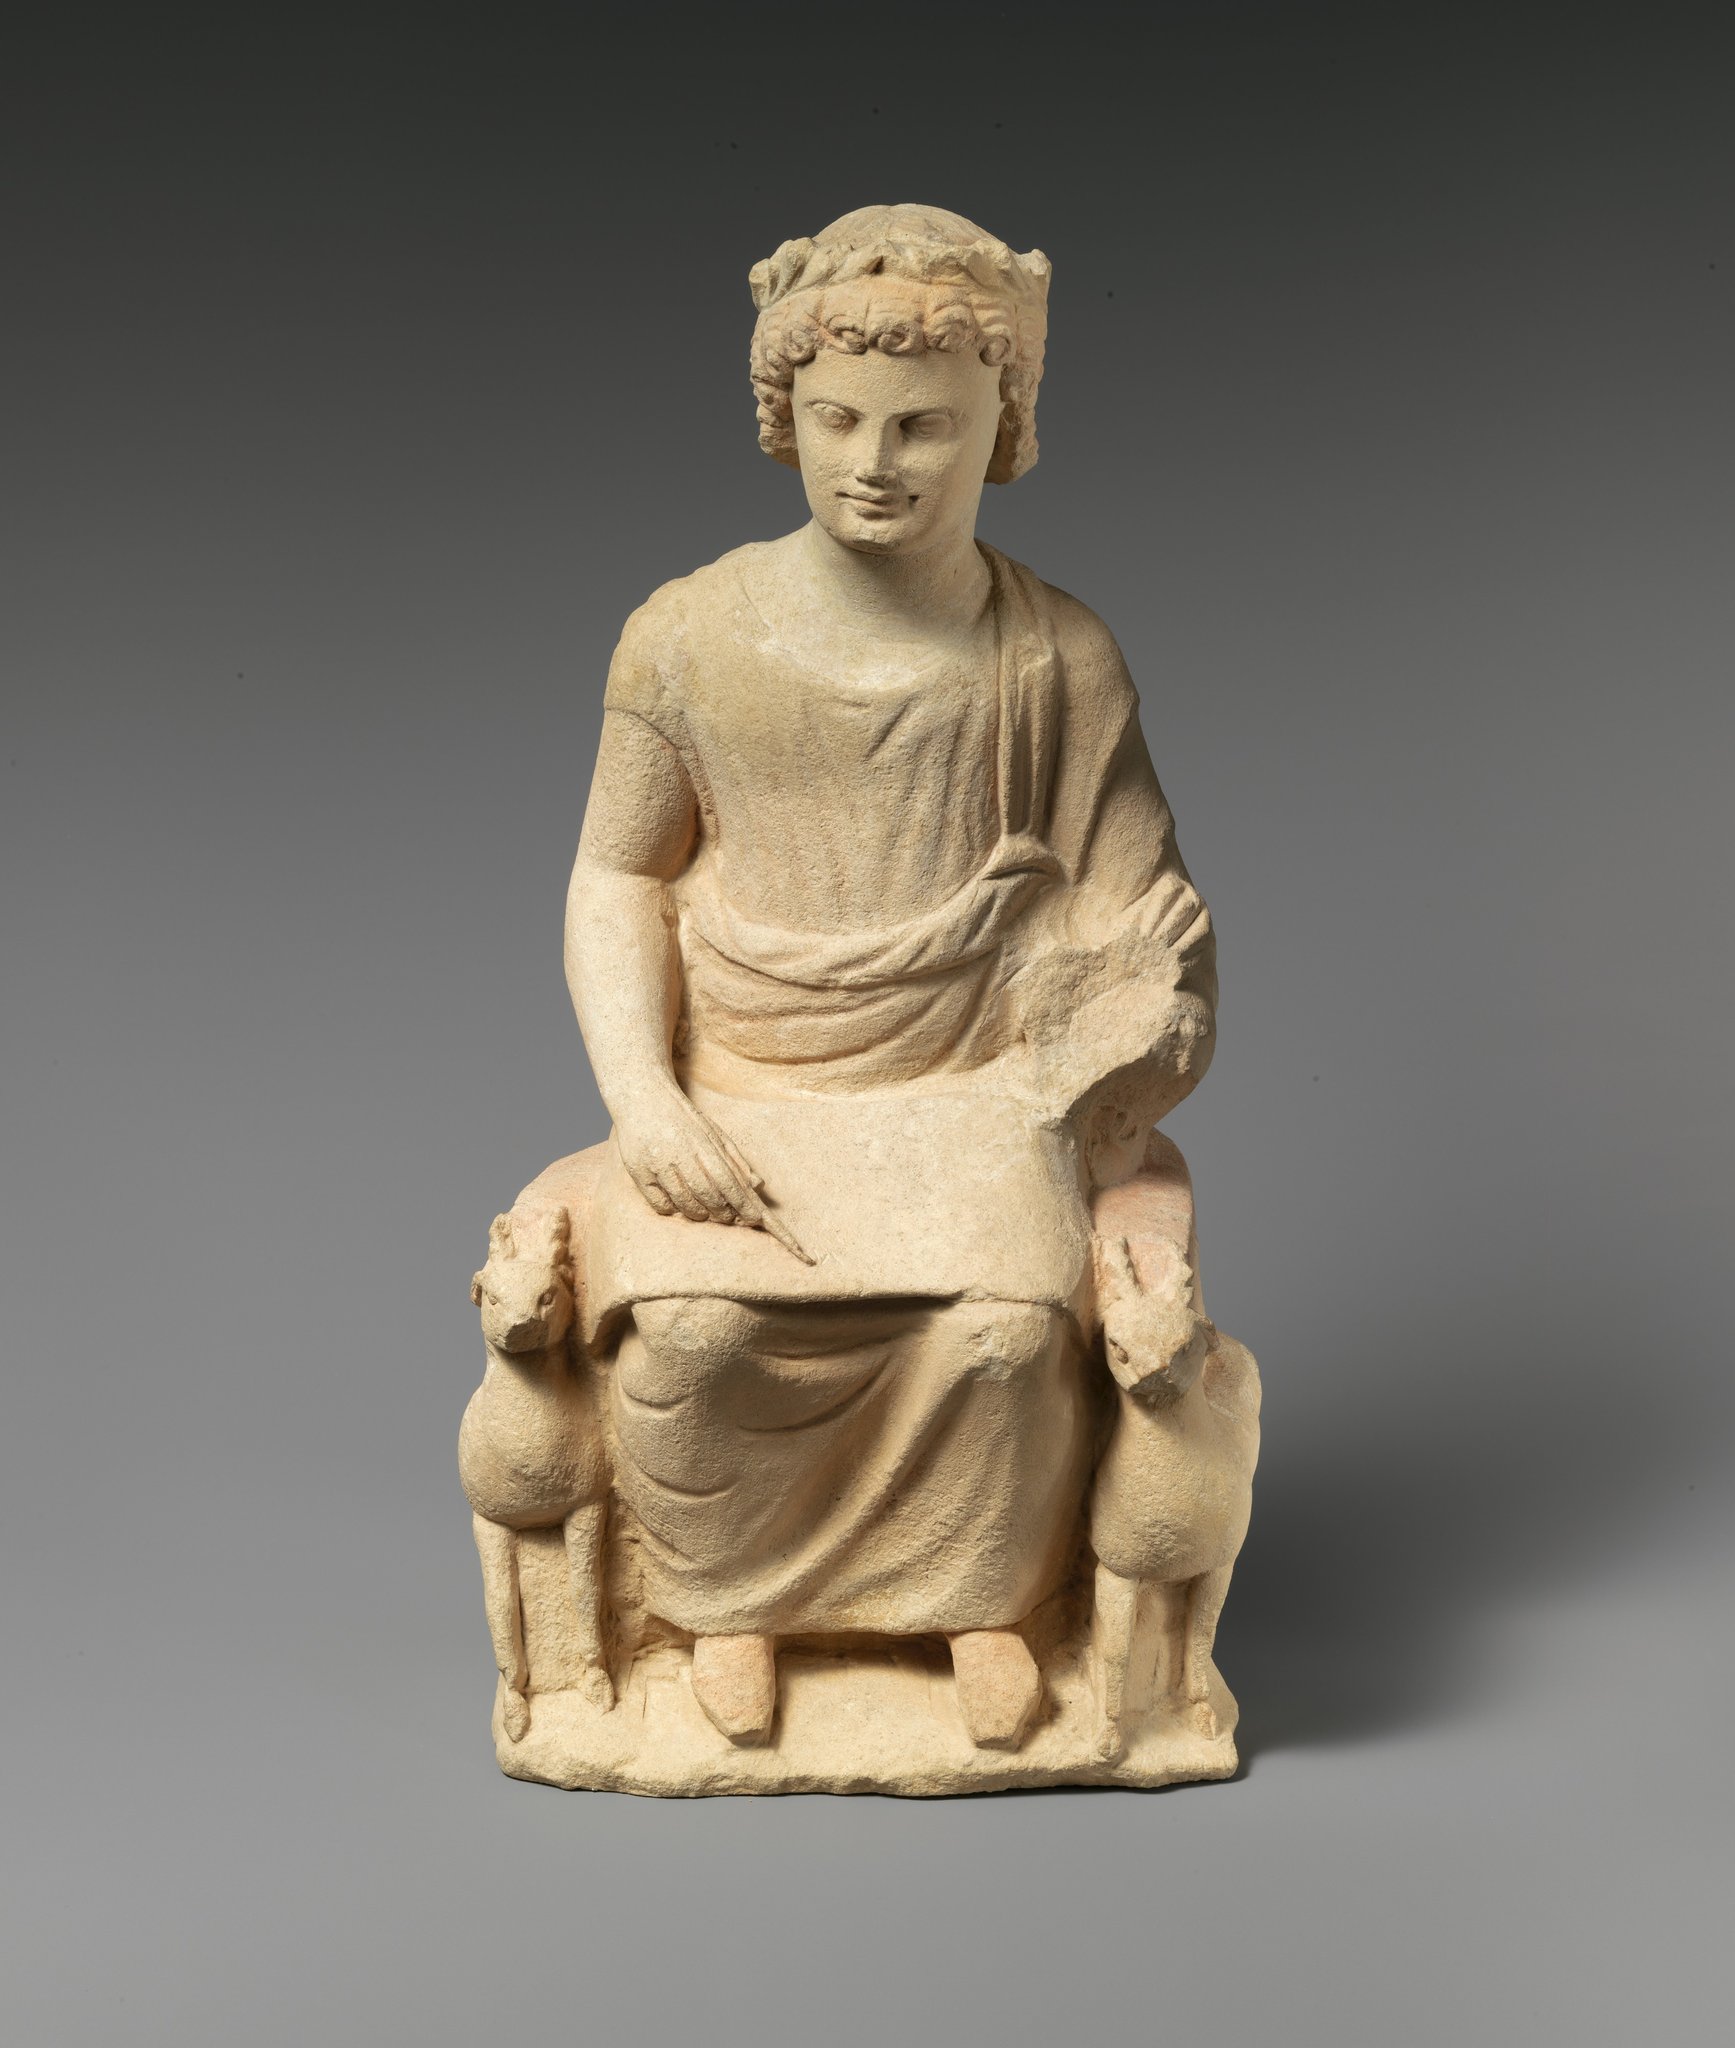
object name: statue of an enthroned youth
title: Limestone statue of an enthroned youth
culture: cypriot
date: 300-201 BCE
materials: limestone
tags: animals,men,writing